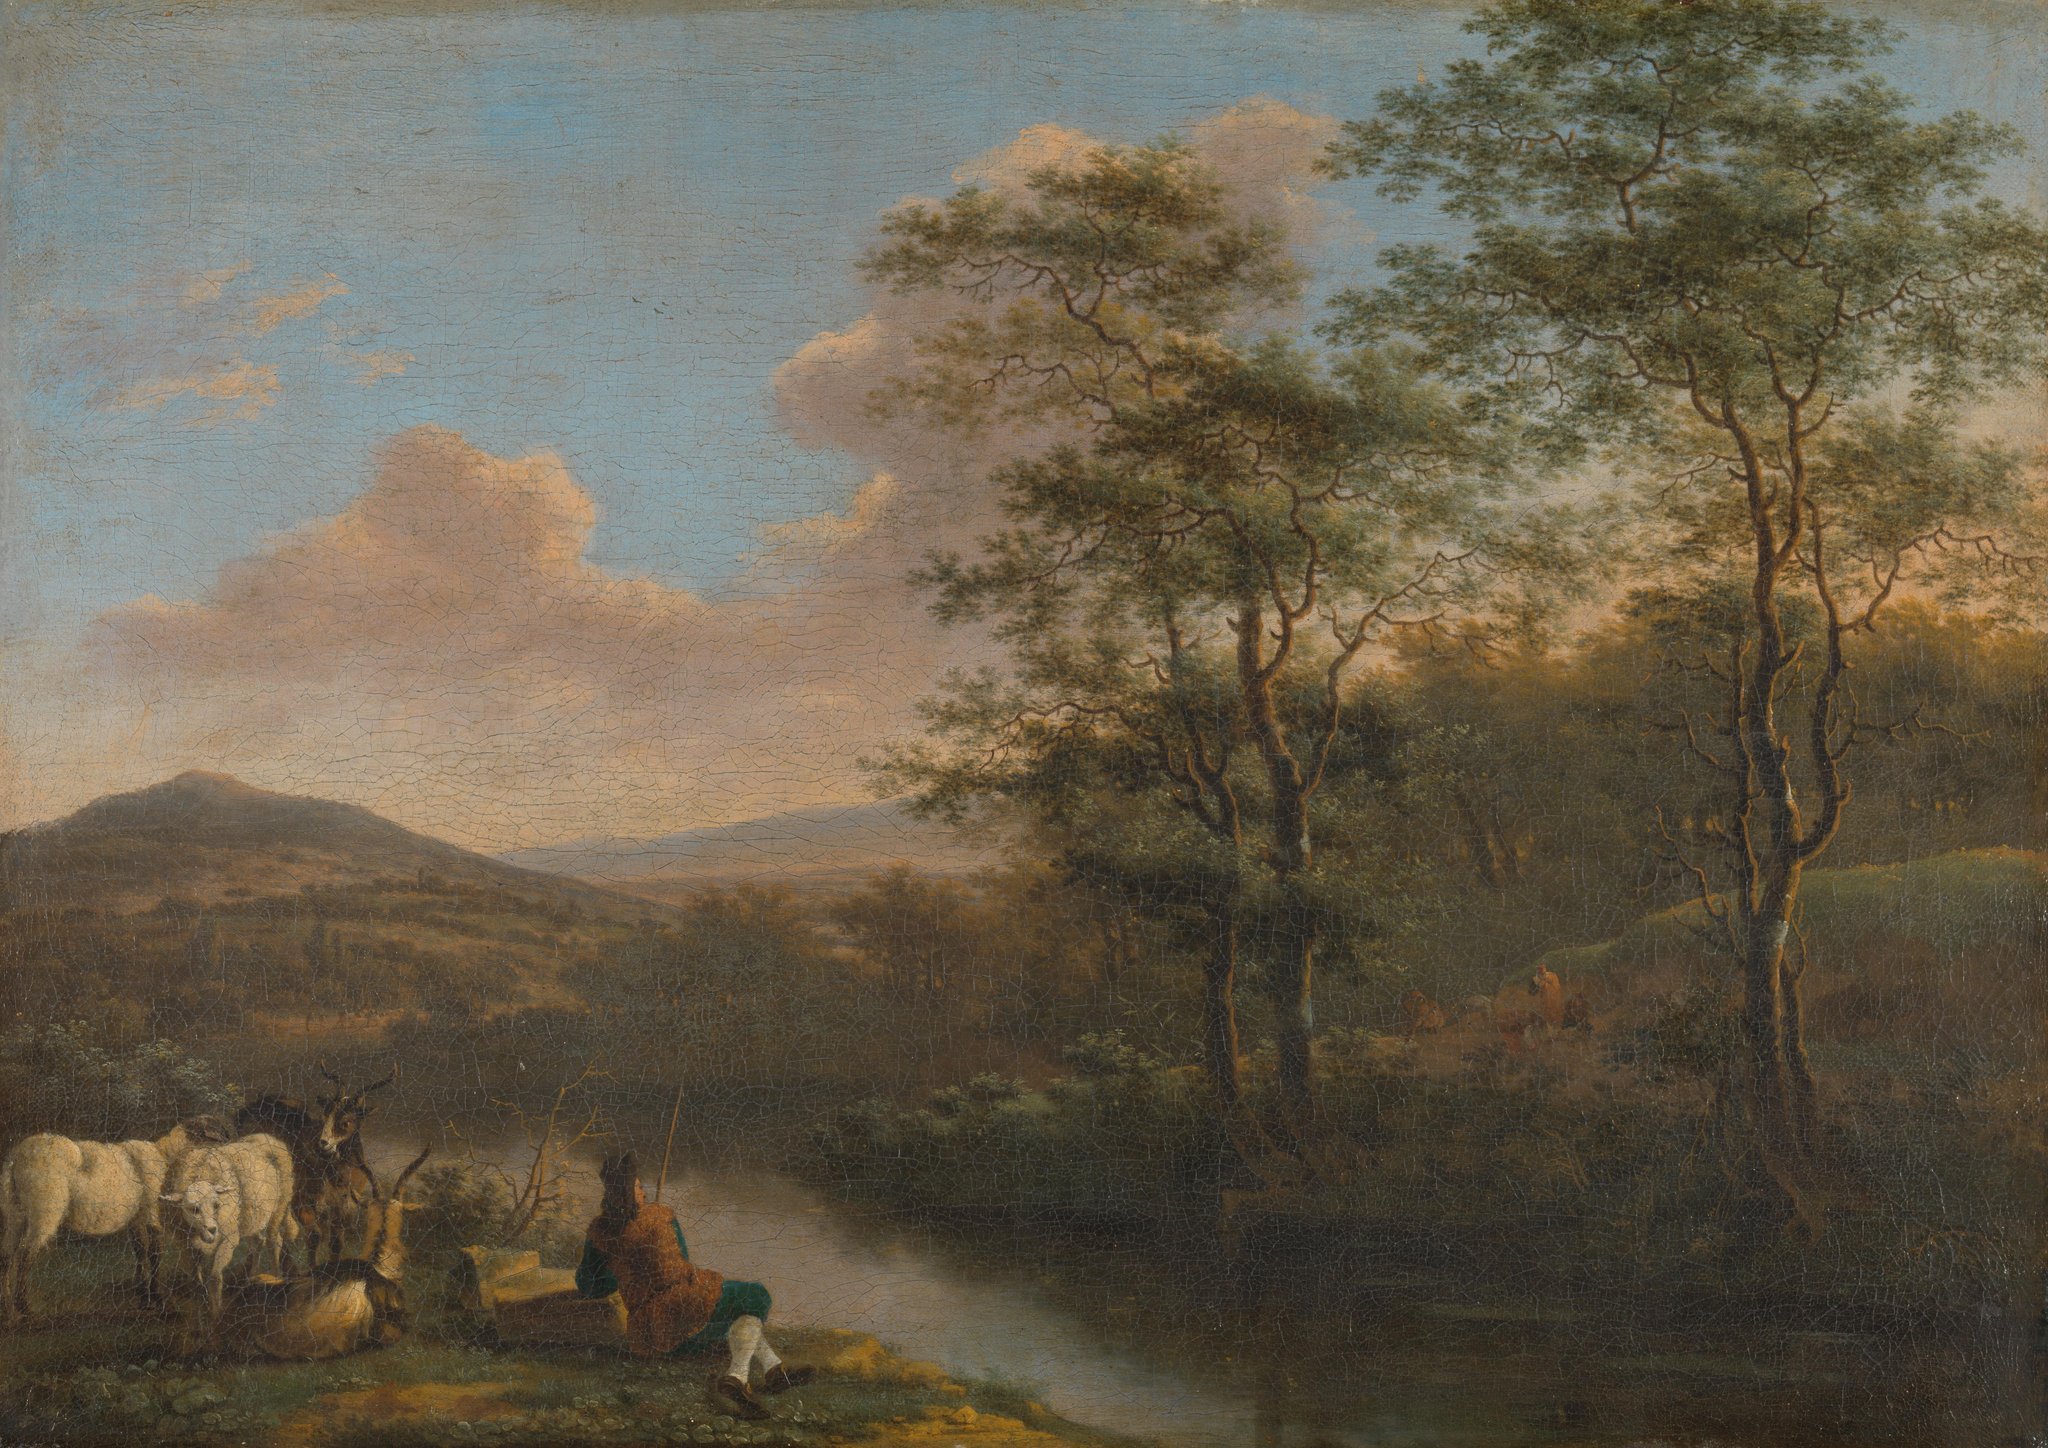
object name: painting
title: Italian Landscape with Resting Herdman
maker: willem de heusch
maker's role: draughtsman, painter, print maker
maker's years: 1625-1692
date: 1650-1692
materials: canvas, oil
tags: river, herding, herdsman, herdswoman, shepherd, shepherdess, cowherd, etc., (high) hill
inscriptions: signature: ‘GDHeusch’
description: Italiaans landschap met rustende herder. De herder ligt met een hengel aan de oever van een rivier. Links twee geiten en twee schapen.